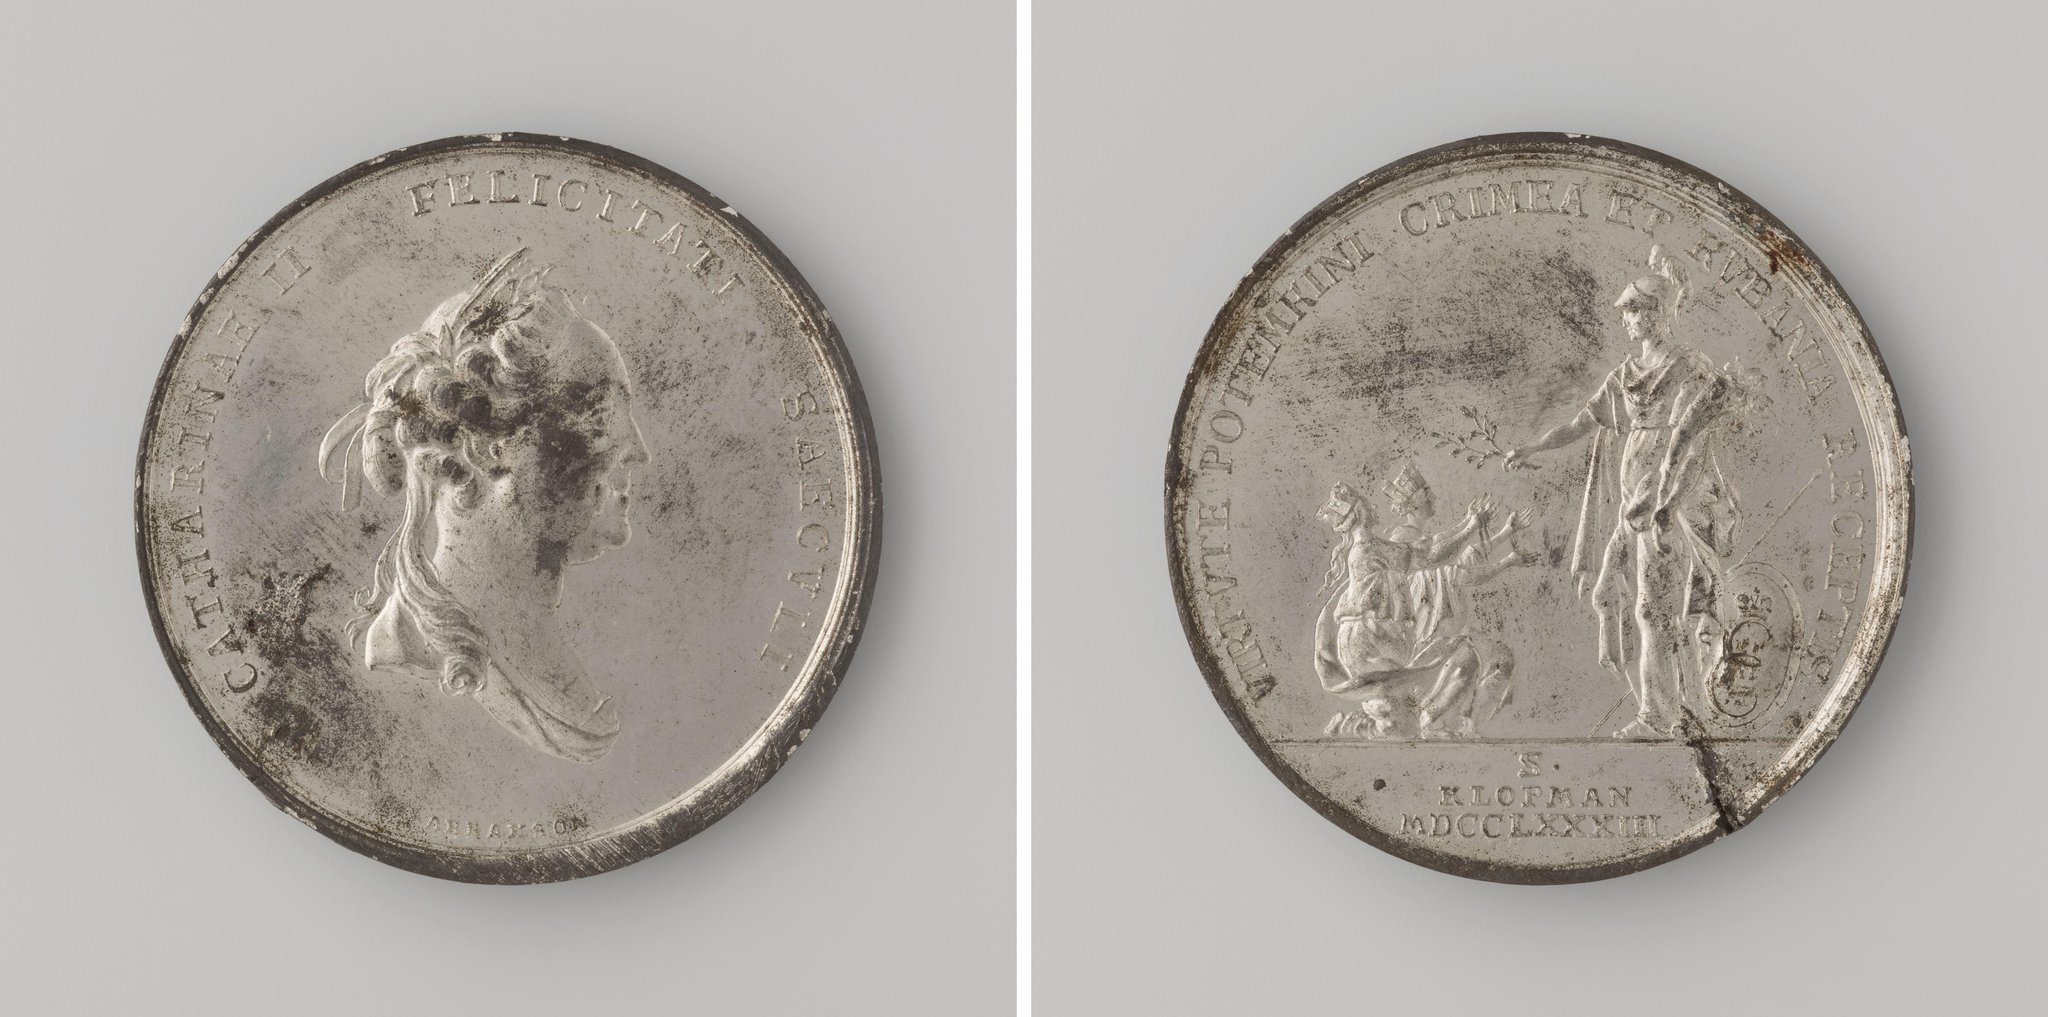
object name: history medal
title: Rusland verwerft de Krim en Kuban op de conventie van Constantinopel, ter ere van Catharina II de Grote, tsarina van Rusland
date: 1784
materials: silver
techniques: striking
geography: berlin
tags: catharina de grote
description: Zilveren penning. Voorzijde: borststuk vrouw met diadeem binnen omschrift. Keerzijde: Rusland, afgebeeld als gehelmde vrouw met gevulde hoorn van overvloed en wapenschild aan haar voeten, overhandigt olijftak aan twee voor haar knielende gekroonde vrouwen binnen omschrift; afsnede: opschrift